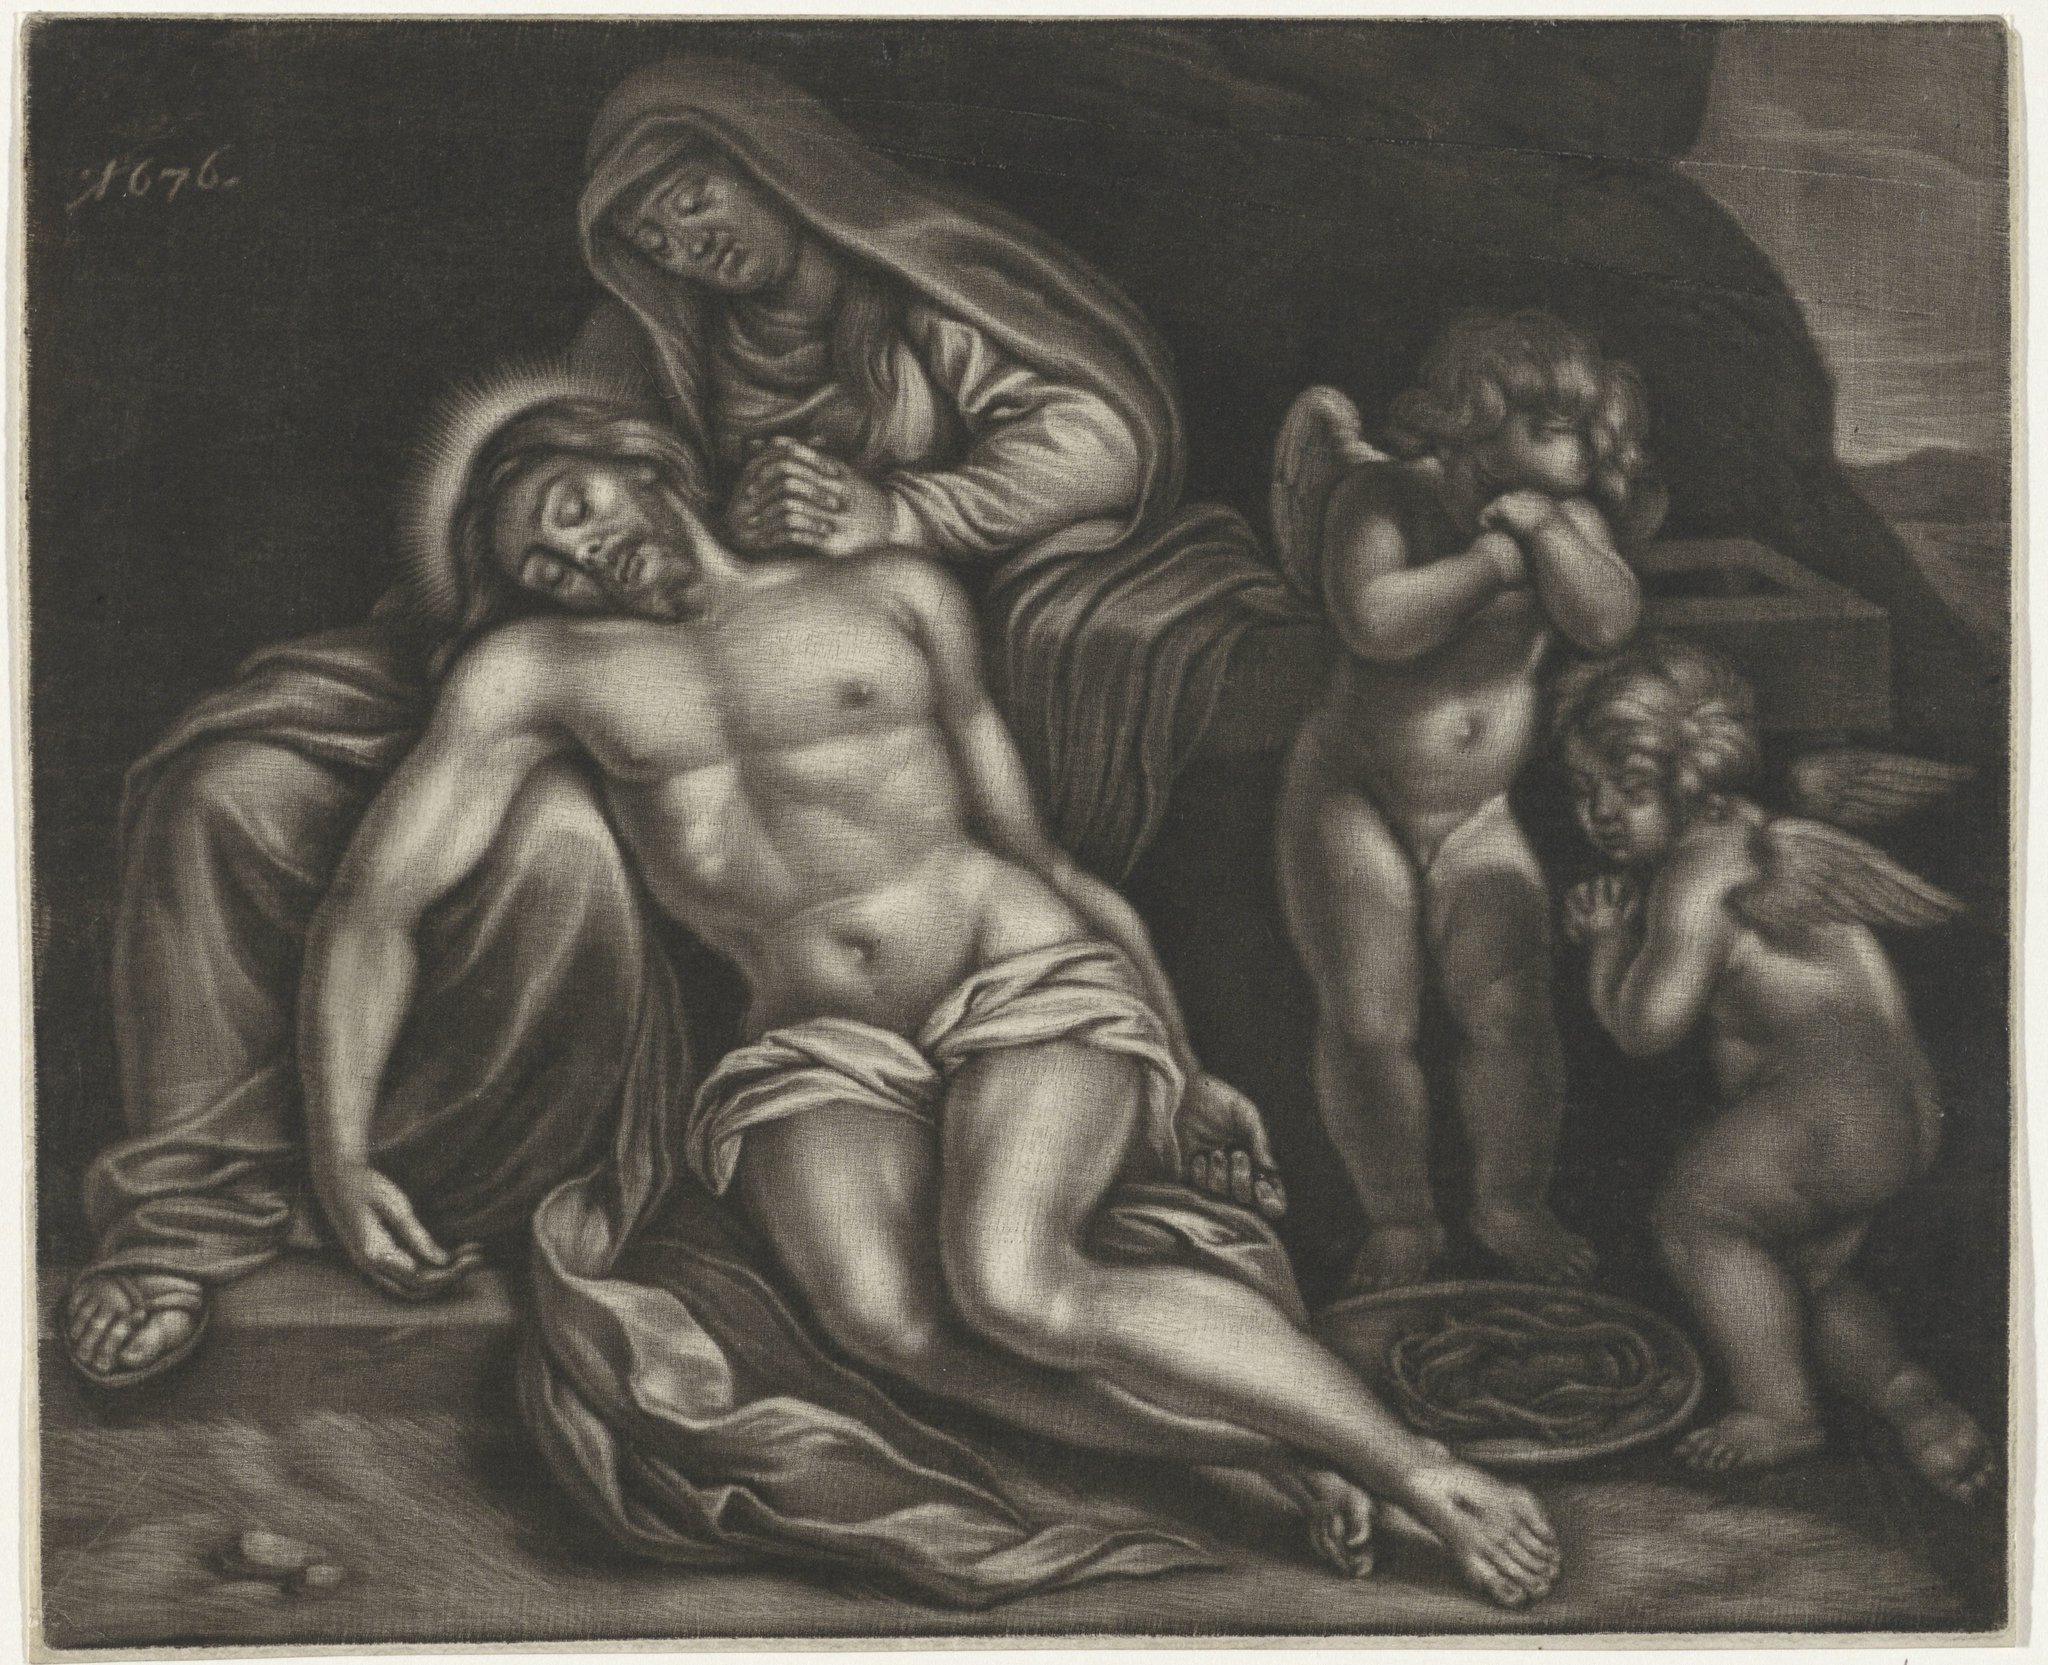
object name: print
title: Piëta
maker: jan van somer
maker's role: draughtsman, print maker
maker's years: 1645-1699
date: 1676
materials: paper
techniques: mezzotint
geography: amsterdam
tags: the dead christ in mary's lap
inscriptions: collector's mark: Lugt 2228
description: Maria beweent de dode Christus, die op haar schoot ligt. Naast haar twee treurende engelen.